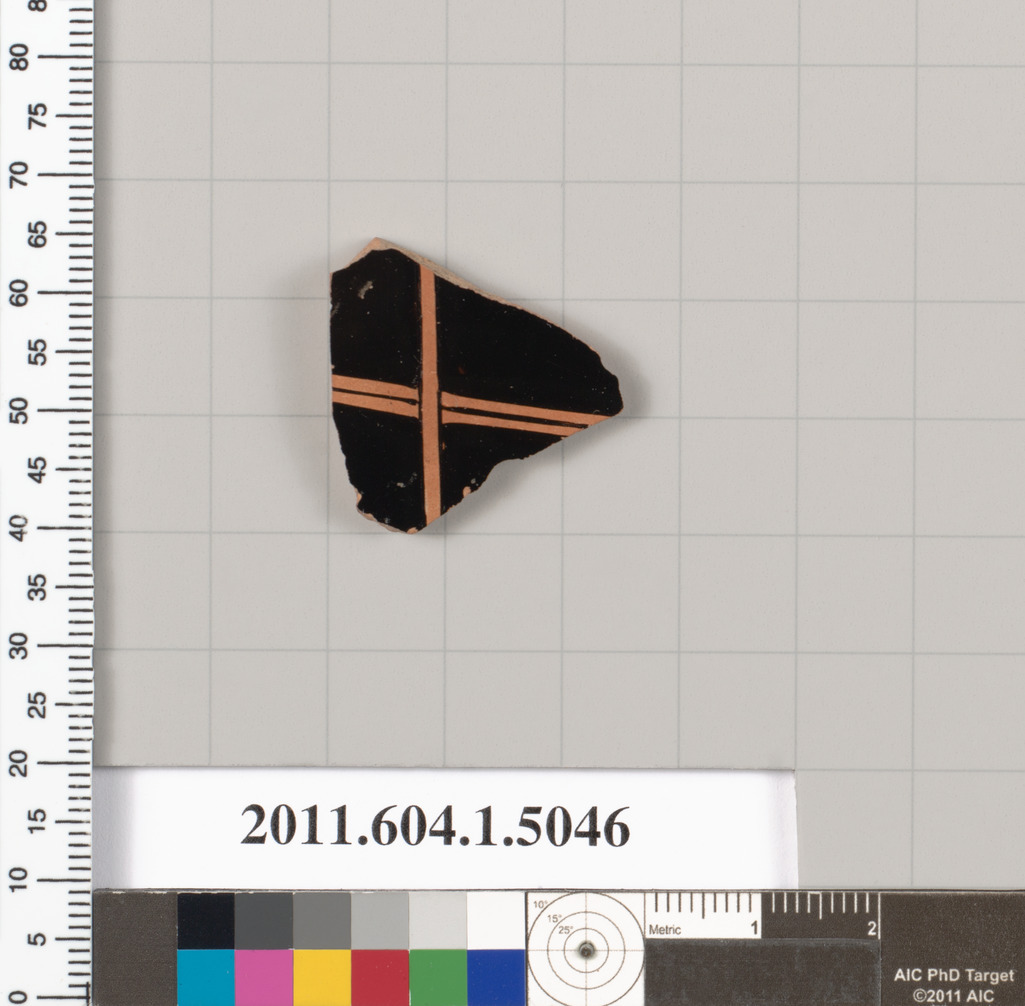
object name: kylix fragment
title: Terracotta fragment of a kylix (drinking cup)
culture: greek, attic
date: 500-480 BCE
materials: terracotta